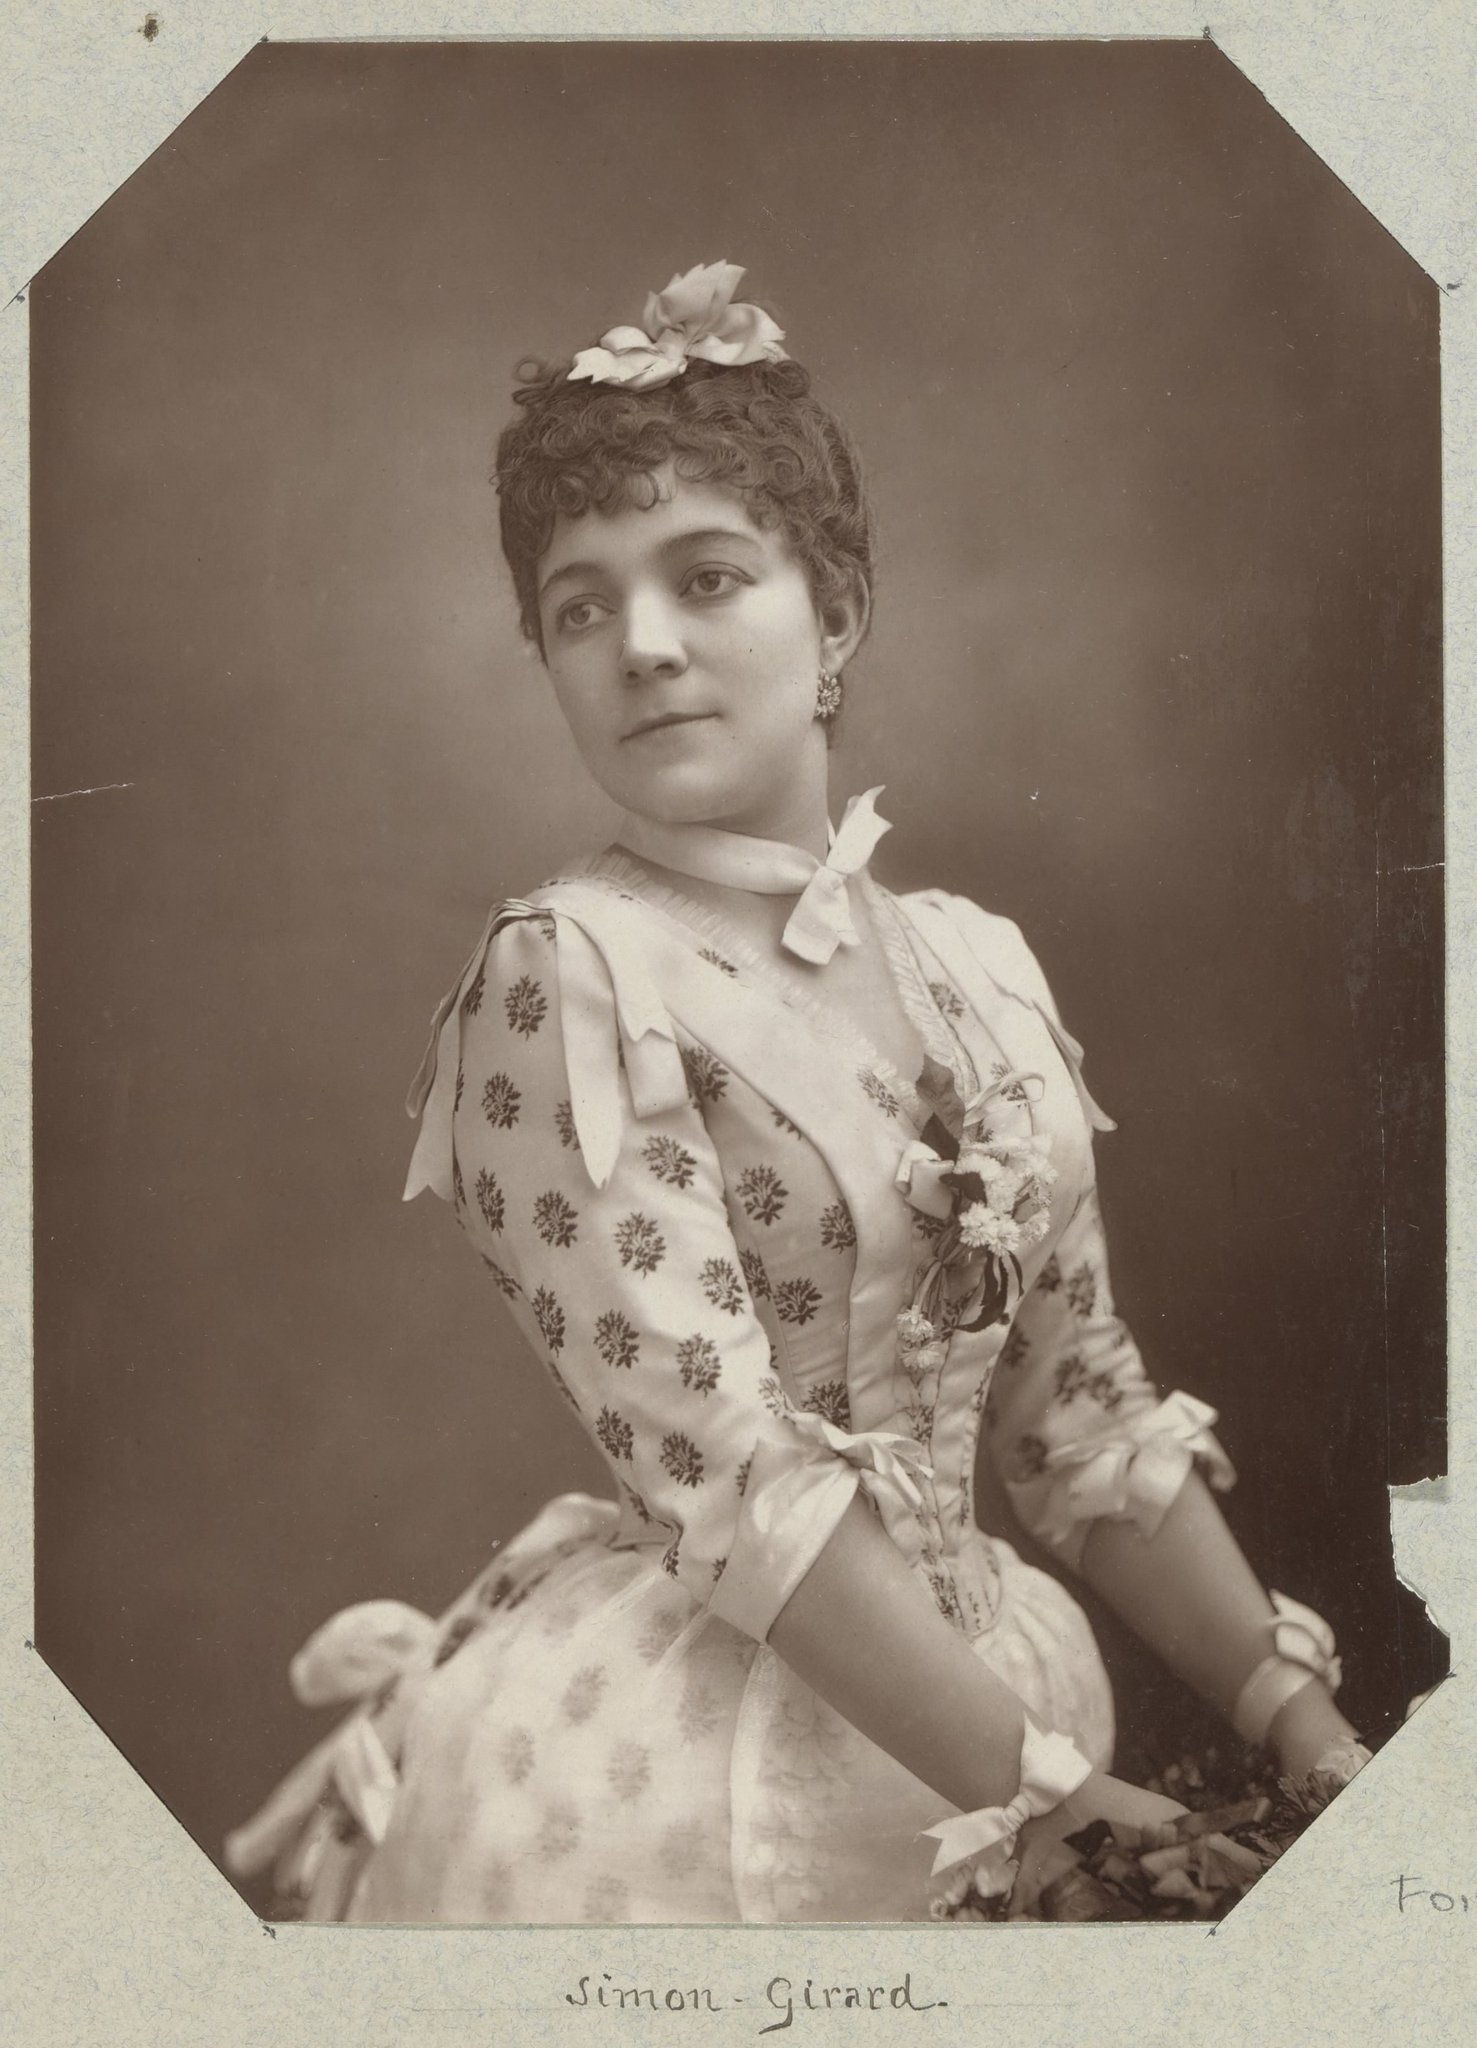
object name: photograph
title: Portret van Simon-Girard, Frans zangeres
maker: Anonymous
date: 1880-1900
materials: paper, photographic support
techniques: carbon print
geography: paris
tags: opera-singer (female), france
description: Onderdeel van Album van een Franse amateur met foto's van Frankrijk, Algerije, Palmyra, de Wereldtentoonstelling van 1900 en van bekende Fransen.